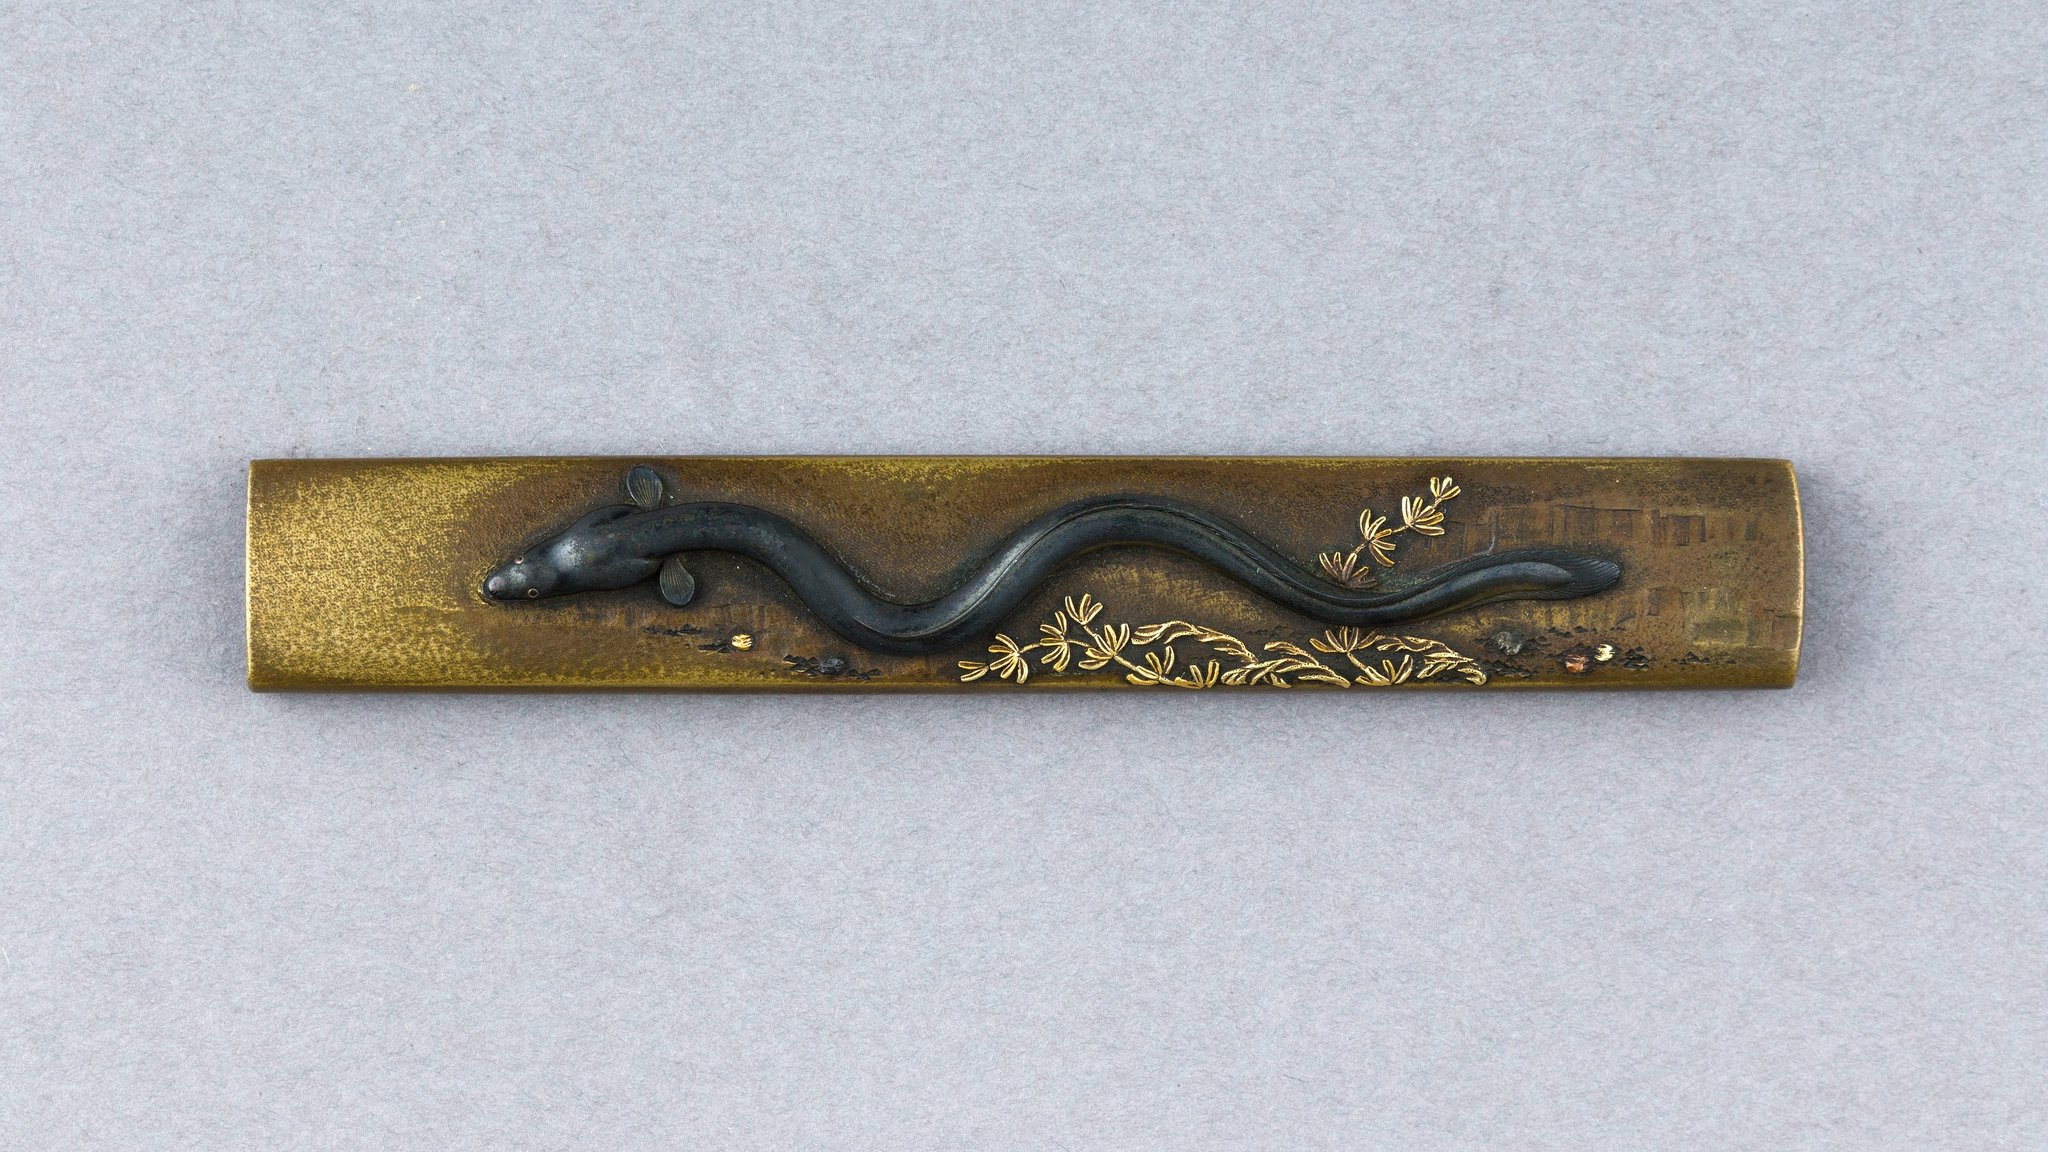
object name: knife handle kozuka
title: Knife Handle (Kozuka)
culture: japanese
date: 1615-1868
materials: copper alloy, gold alloy, gold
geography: japan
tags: fish